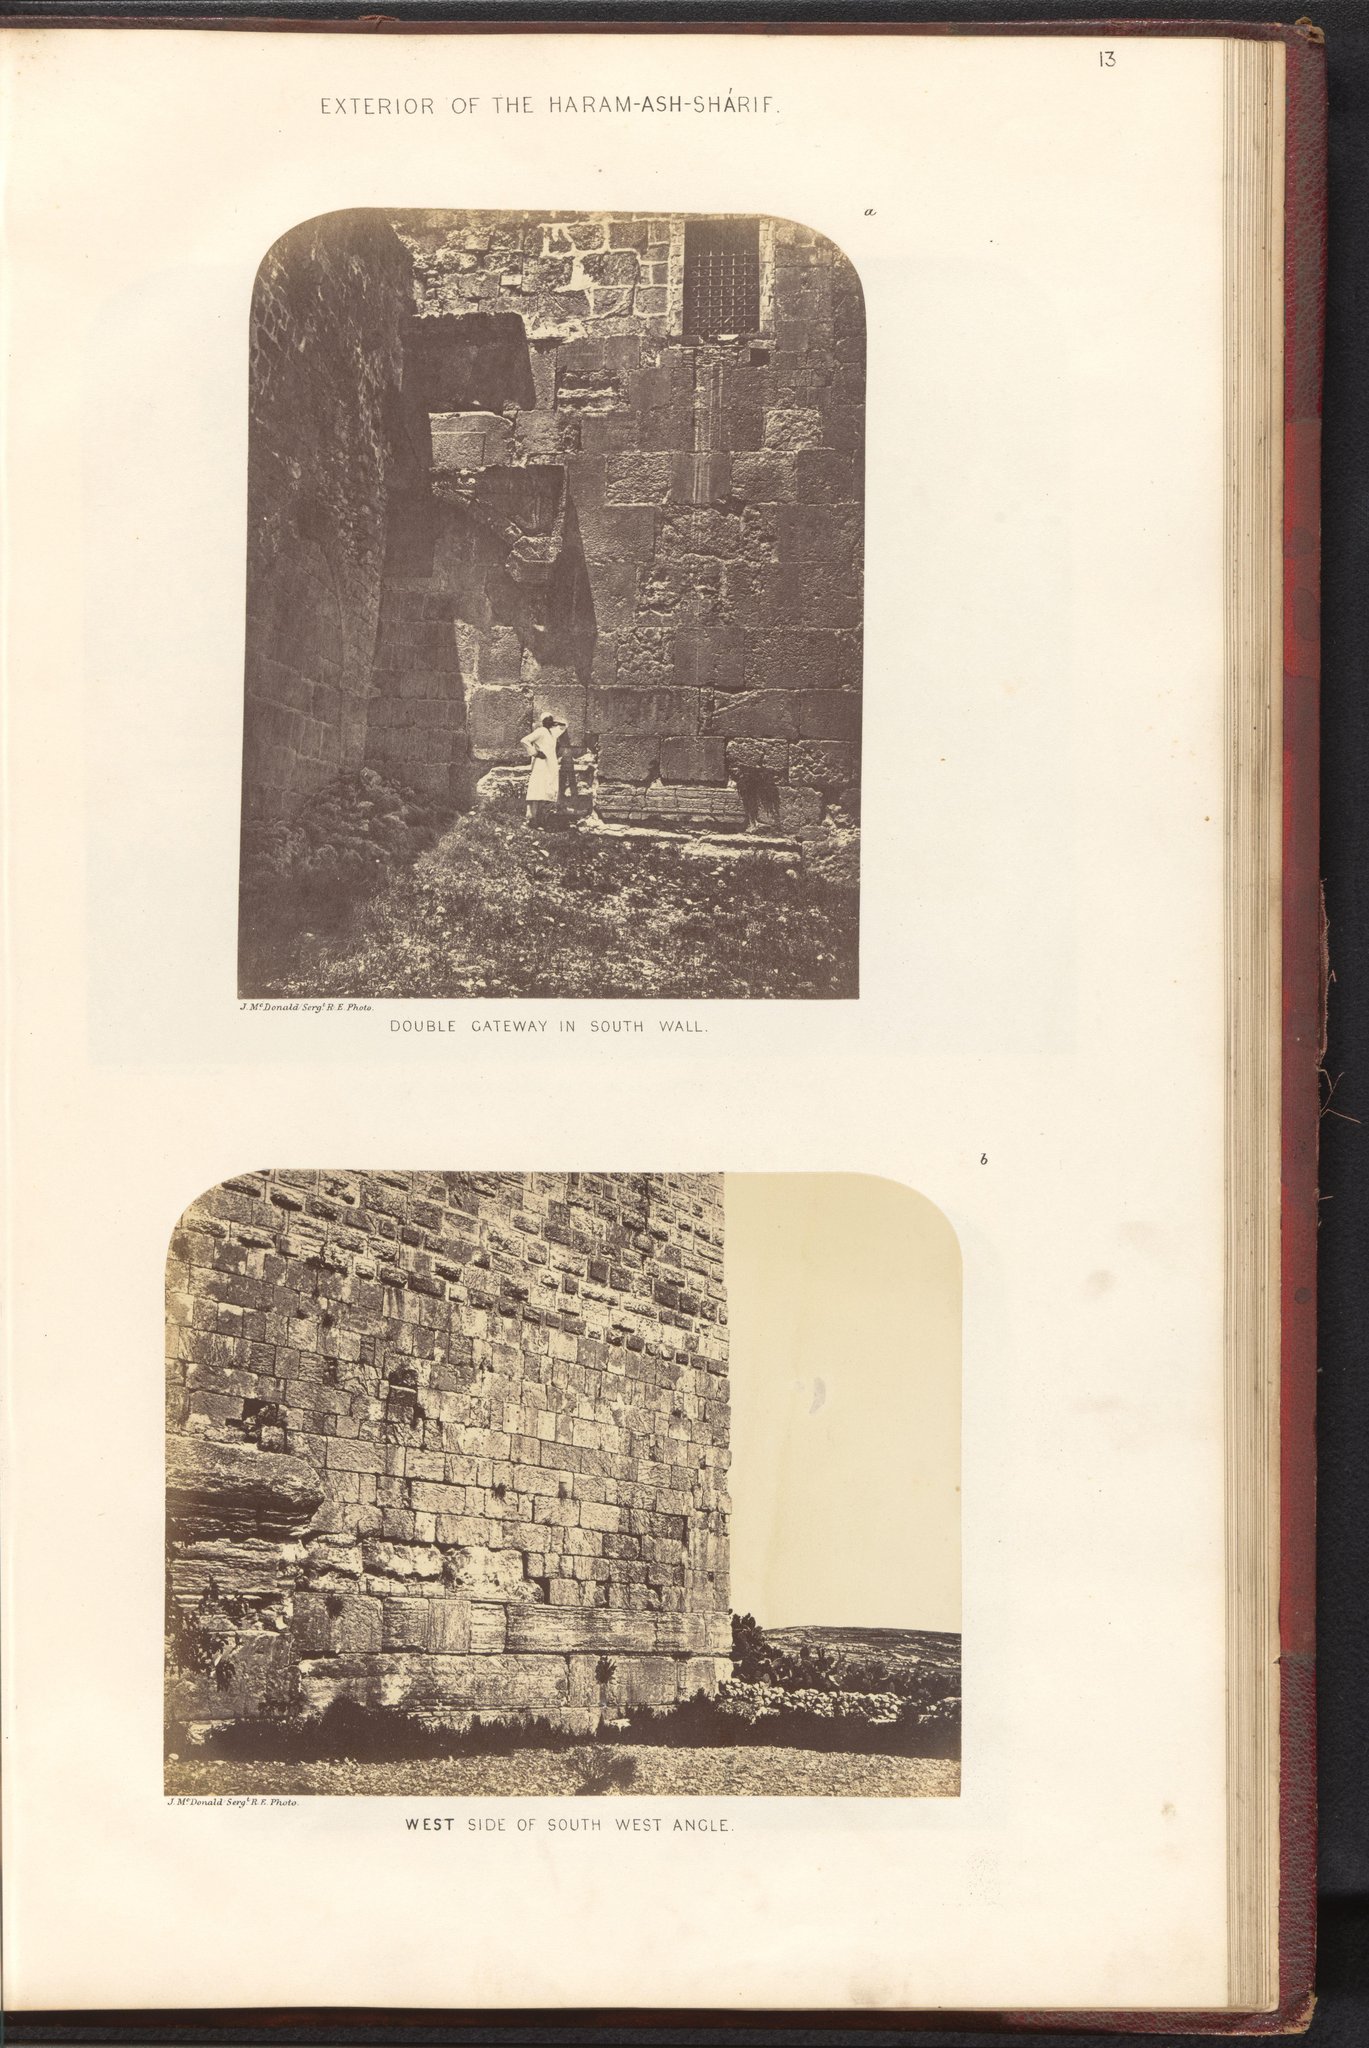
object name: page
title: West Side of South West Angle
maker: james mcdonald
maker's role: fotograaf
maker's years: 1822-1885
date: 1860-1865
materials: paper, photographic support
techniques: albumen print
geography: tempelberg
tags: city-walls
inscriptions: inscription: ‘a’, inscription: ‘b’